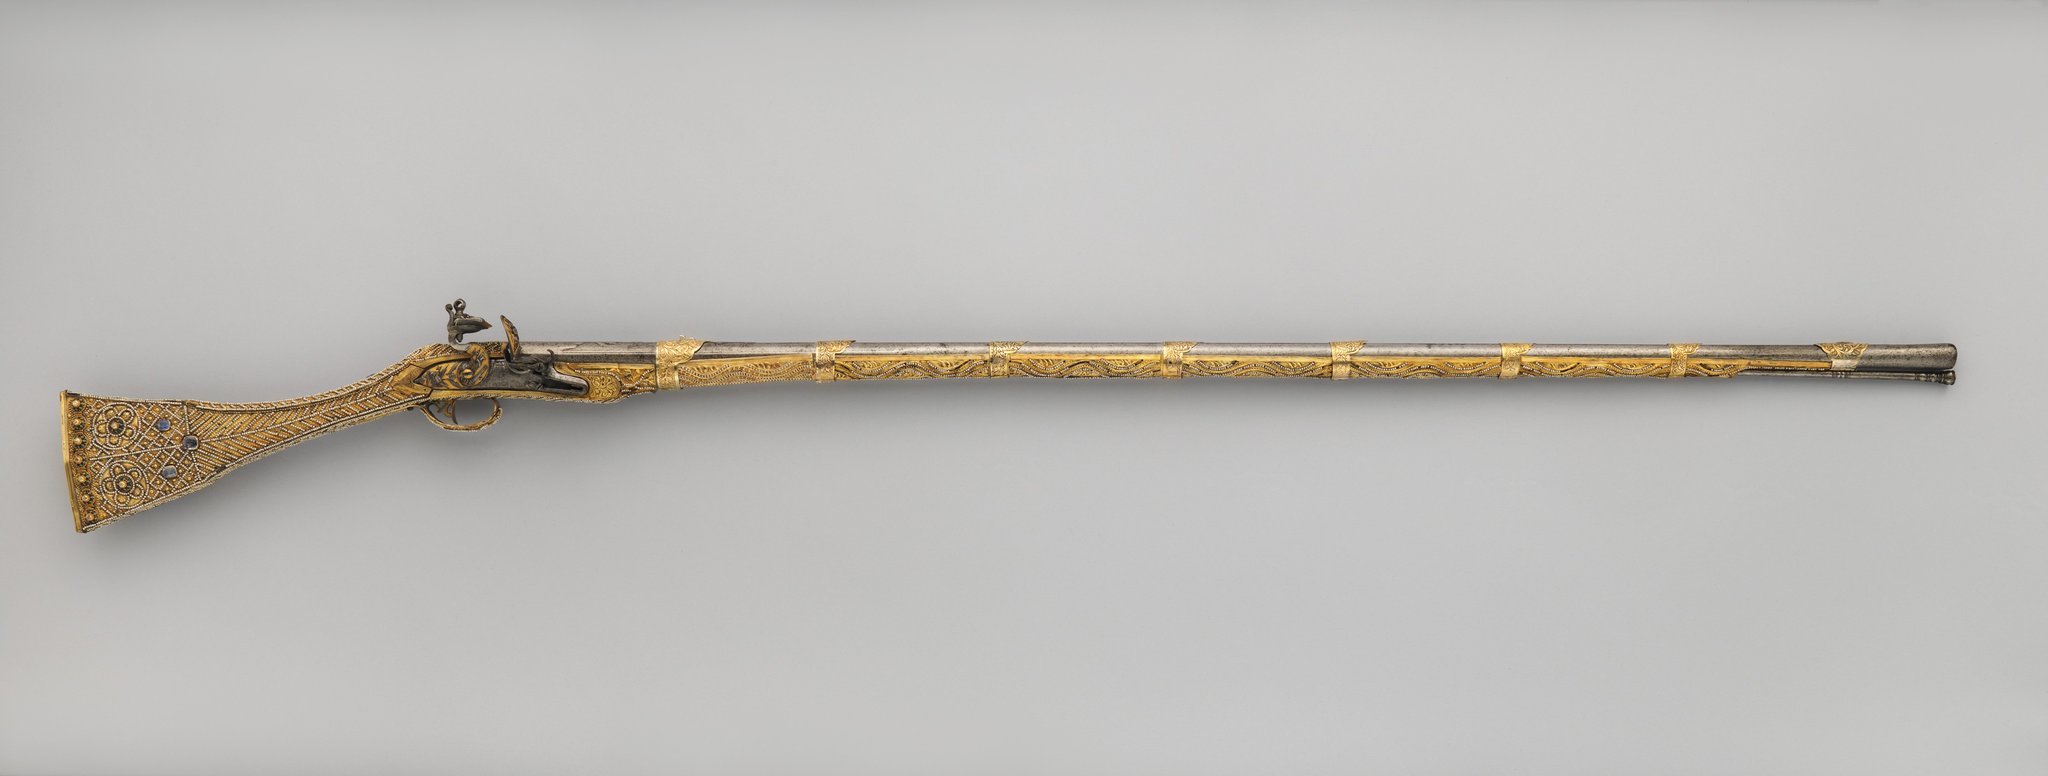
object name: flintlock pistol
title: Flintlock Gun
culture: gun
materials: diamond, enamel, gemstone, gold, iron, pearl, silver, wood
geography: france